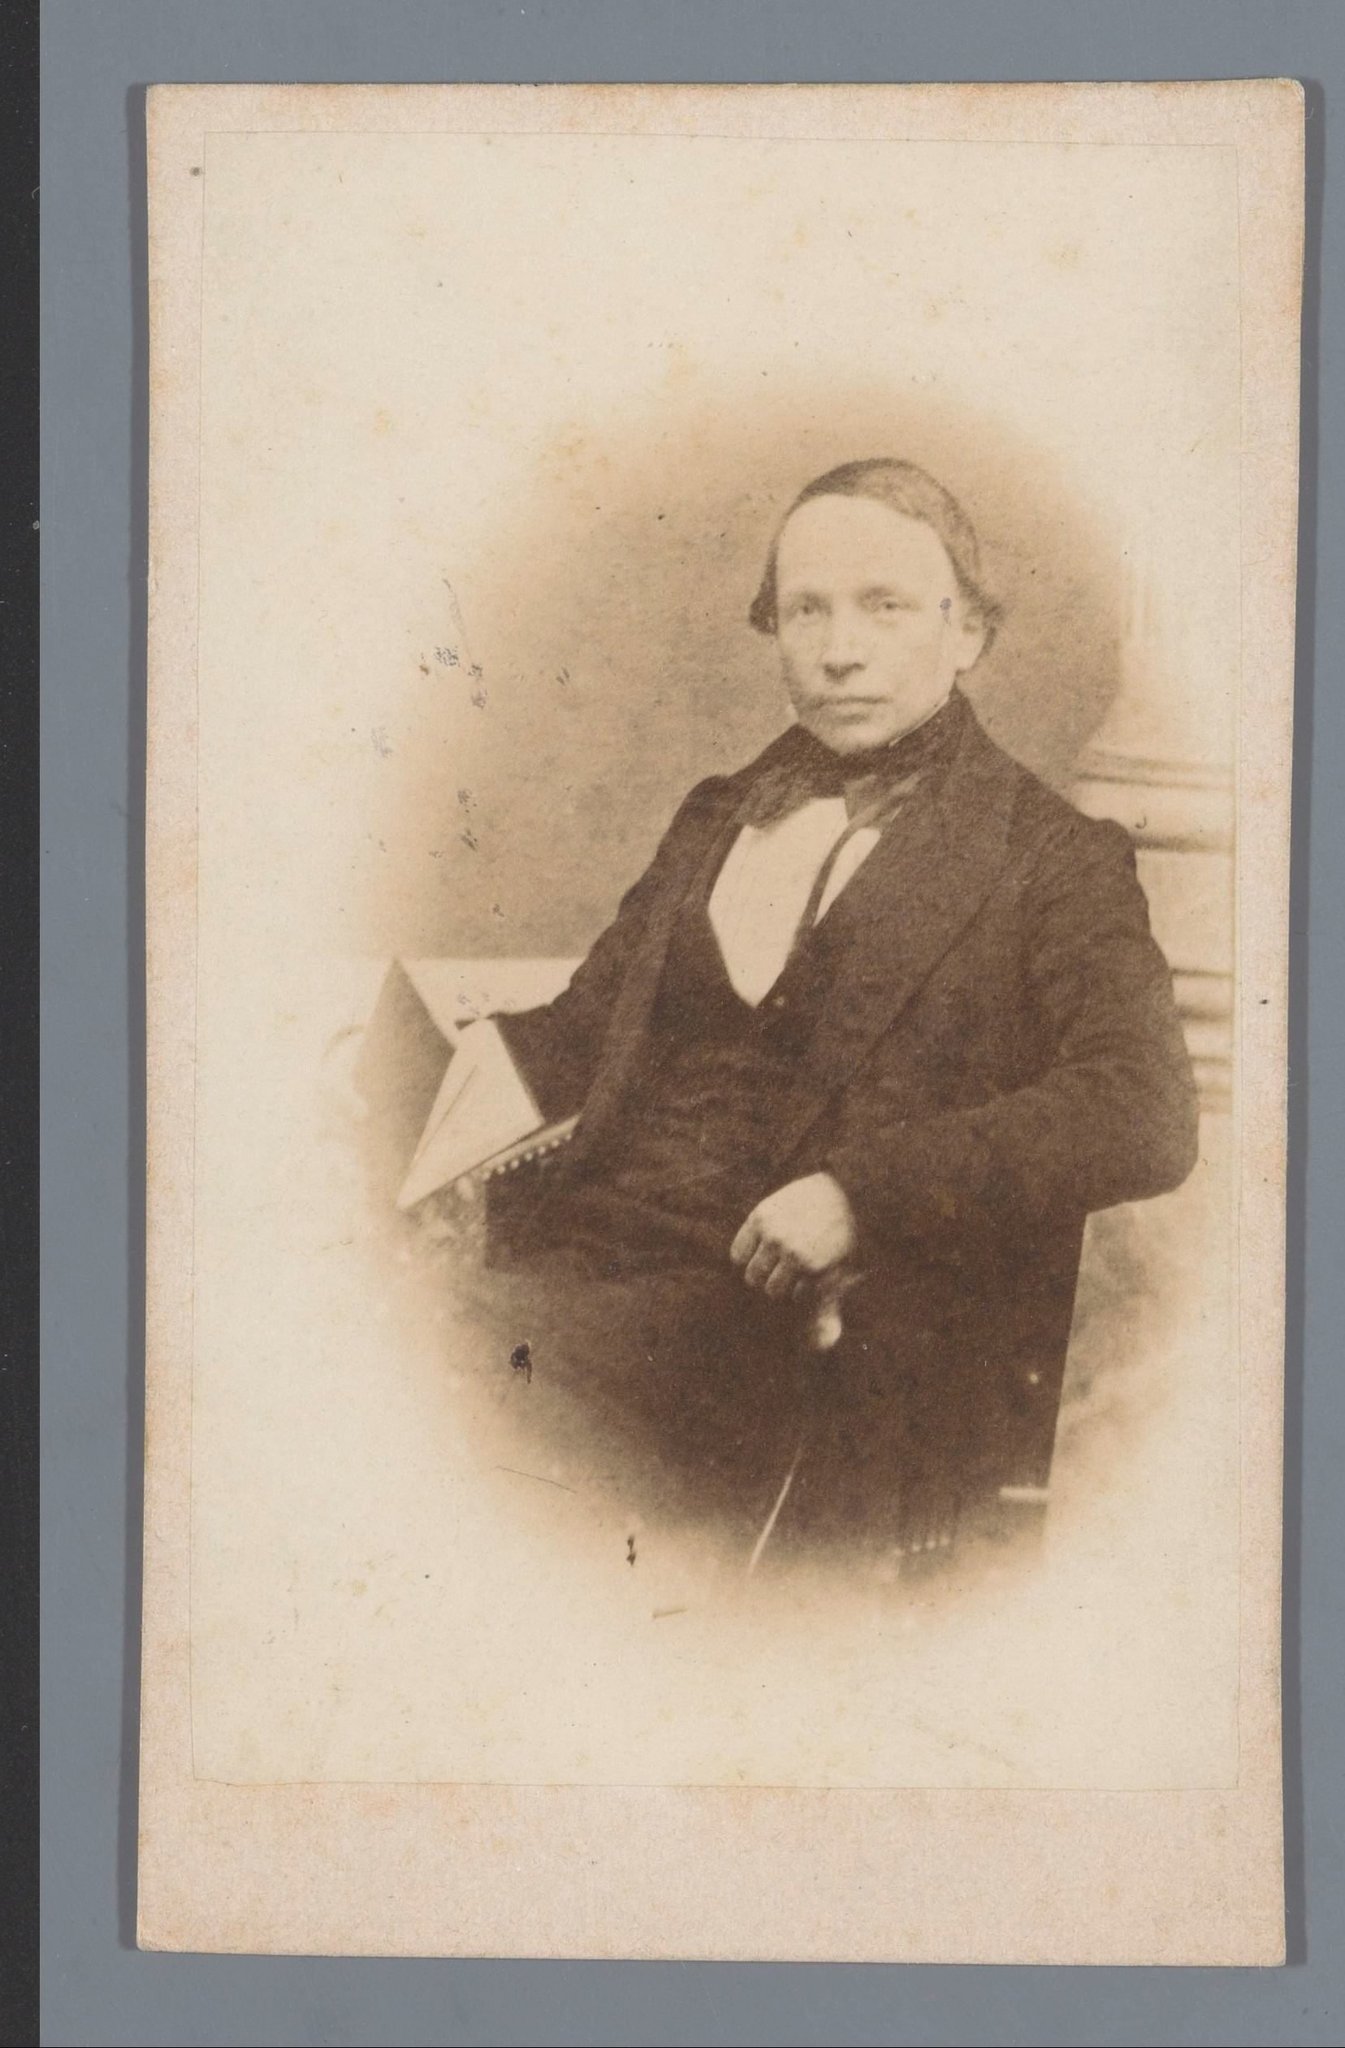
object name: photograph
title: W. Gleuns jr.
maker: Anonymous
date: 1878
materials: cardboard, paper, photographic support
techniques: albumen print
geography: netherlands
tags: historical persons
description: Carte-de-visite is onderdeel van een groep portretten aangeboden aan A.J. Nijland, verzamelaar van historieprenten.